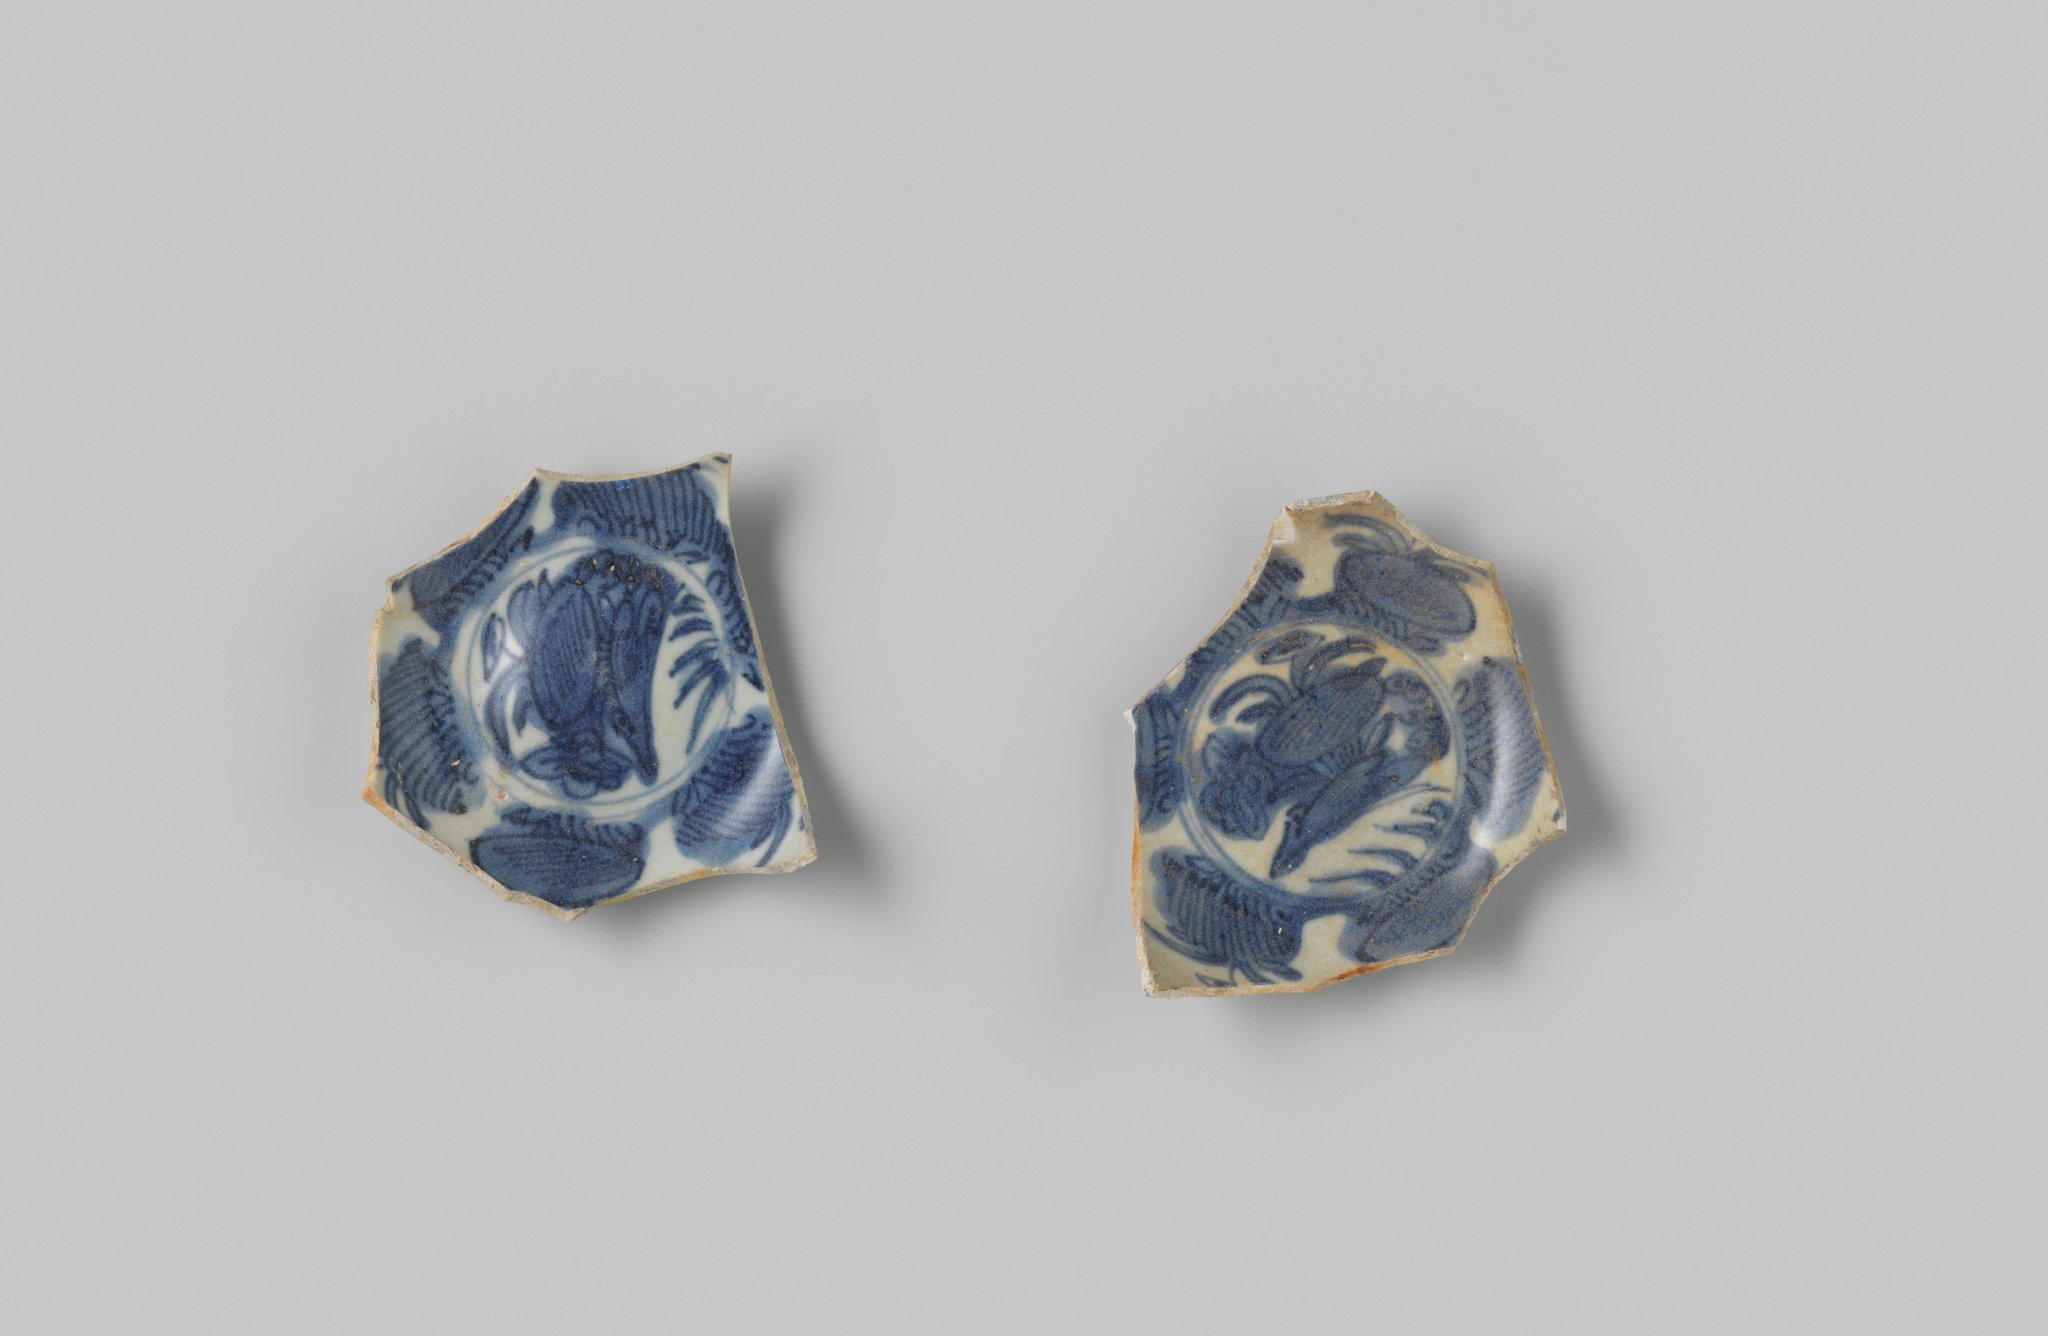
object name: platter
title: Fragmenten van schotels van porselein uit V.O.C.-schip de 'Witte Leeuw'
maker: Anonymous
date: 1613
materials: porcelain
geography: jingdezhen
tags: verenigde oostindische compagnie, sint-helena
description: Fragmenten van schotels van porselein uit V.O.C.-schip de 'Witte Leeuw'. Bodemfragmenten.